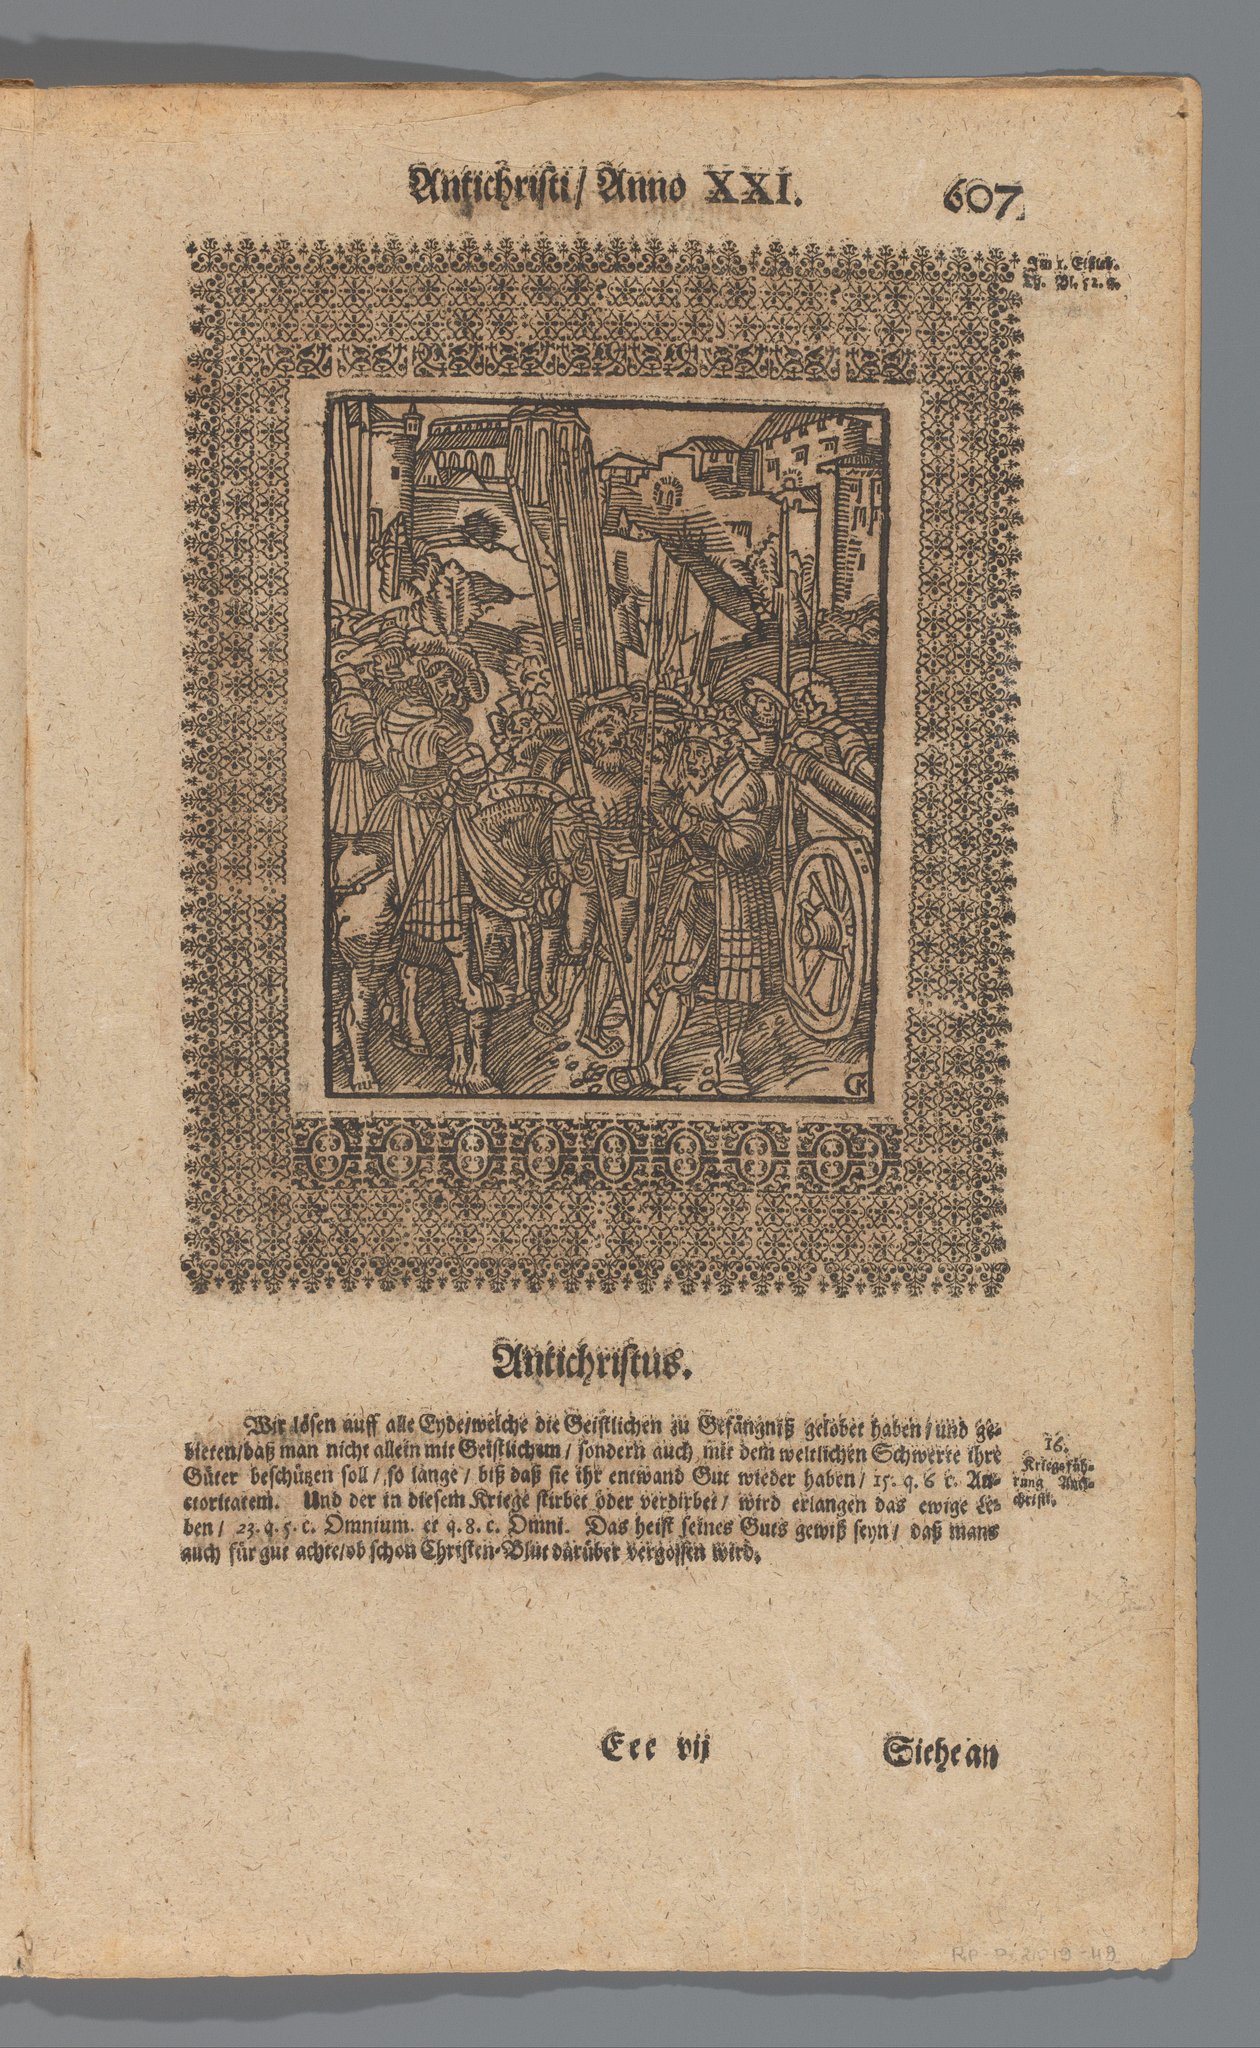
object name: print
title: Paus voert het bevel over een leger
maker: monogrammist gk (prentmaker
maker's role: print maker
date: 1661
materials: paper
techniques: letterpress printing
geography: europe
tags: the richness of the church opposed to christ's humility, war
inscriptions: collector's mark: Lugt 2228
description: Paus voert het bevel over een machtig leger. Tegenstelling over bezit. Spiegelbeeldige kopie naar de prent van Lucas Cranach in het pamflet 'Passional Christi und Antichristi' van Martin Luther uit 1521, bladzijde 607 uit een 17e-eeuwse uitgave. De reeks van dertien paar houtsneden geeft de tegenstellingen weer tussen de nederigheid en onbaatzuchtigheid van Christus enerzijds, en de trots en hebzucht van de paus anderzijds.